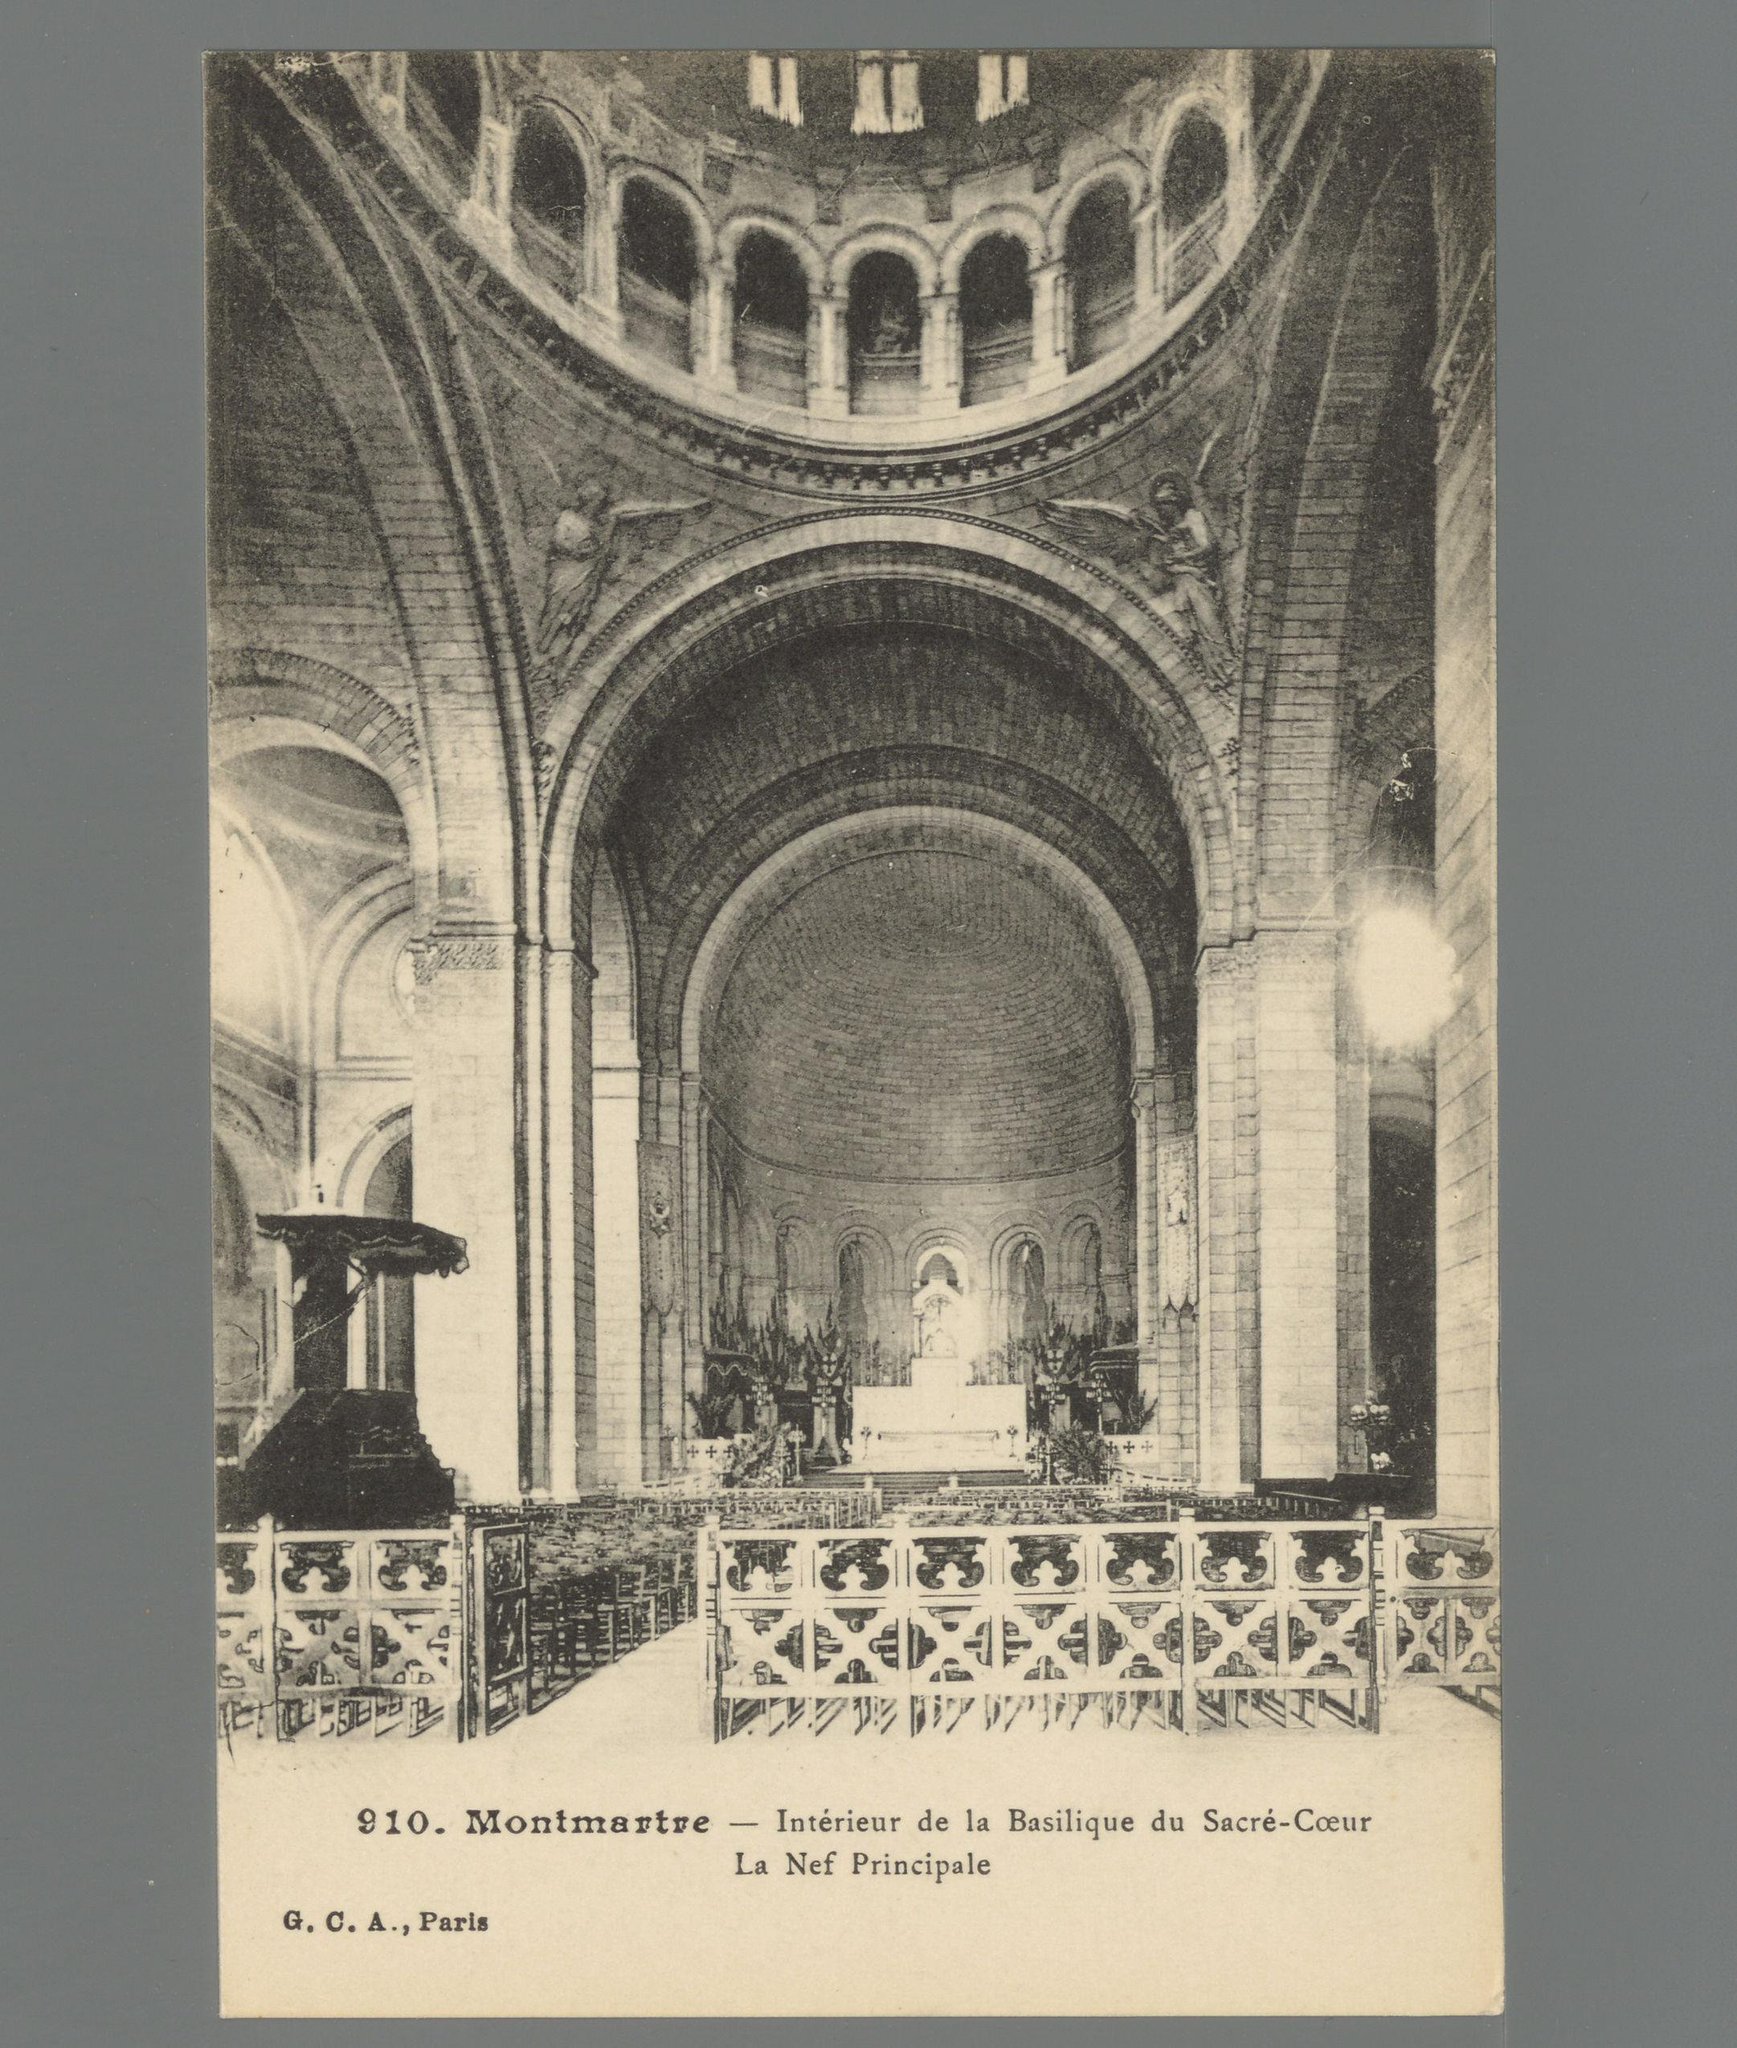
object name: ansichtkaart, prentbriefkaart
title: Montmartre. Intérieur de la Basilique du Sacré-Coeur. La Nef Principale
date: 1903-1920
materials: cardboard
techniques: photograph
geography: paris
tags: parts of church interior: nave